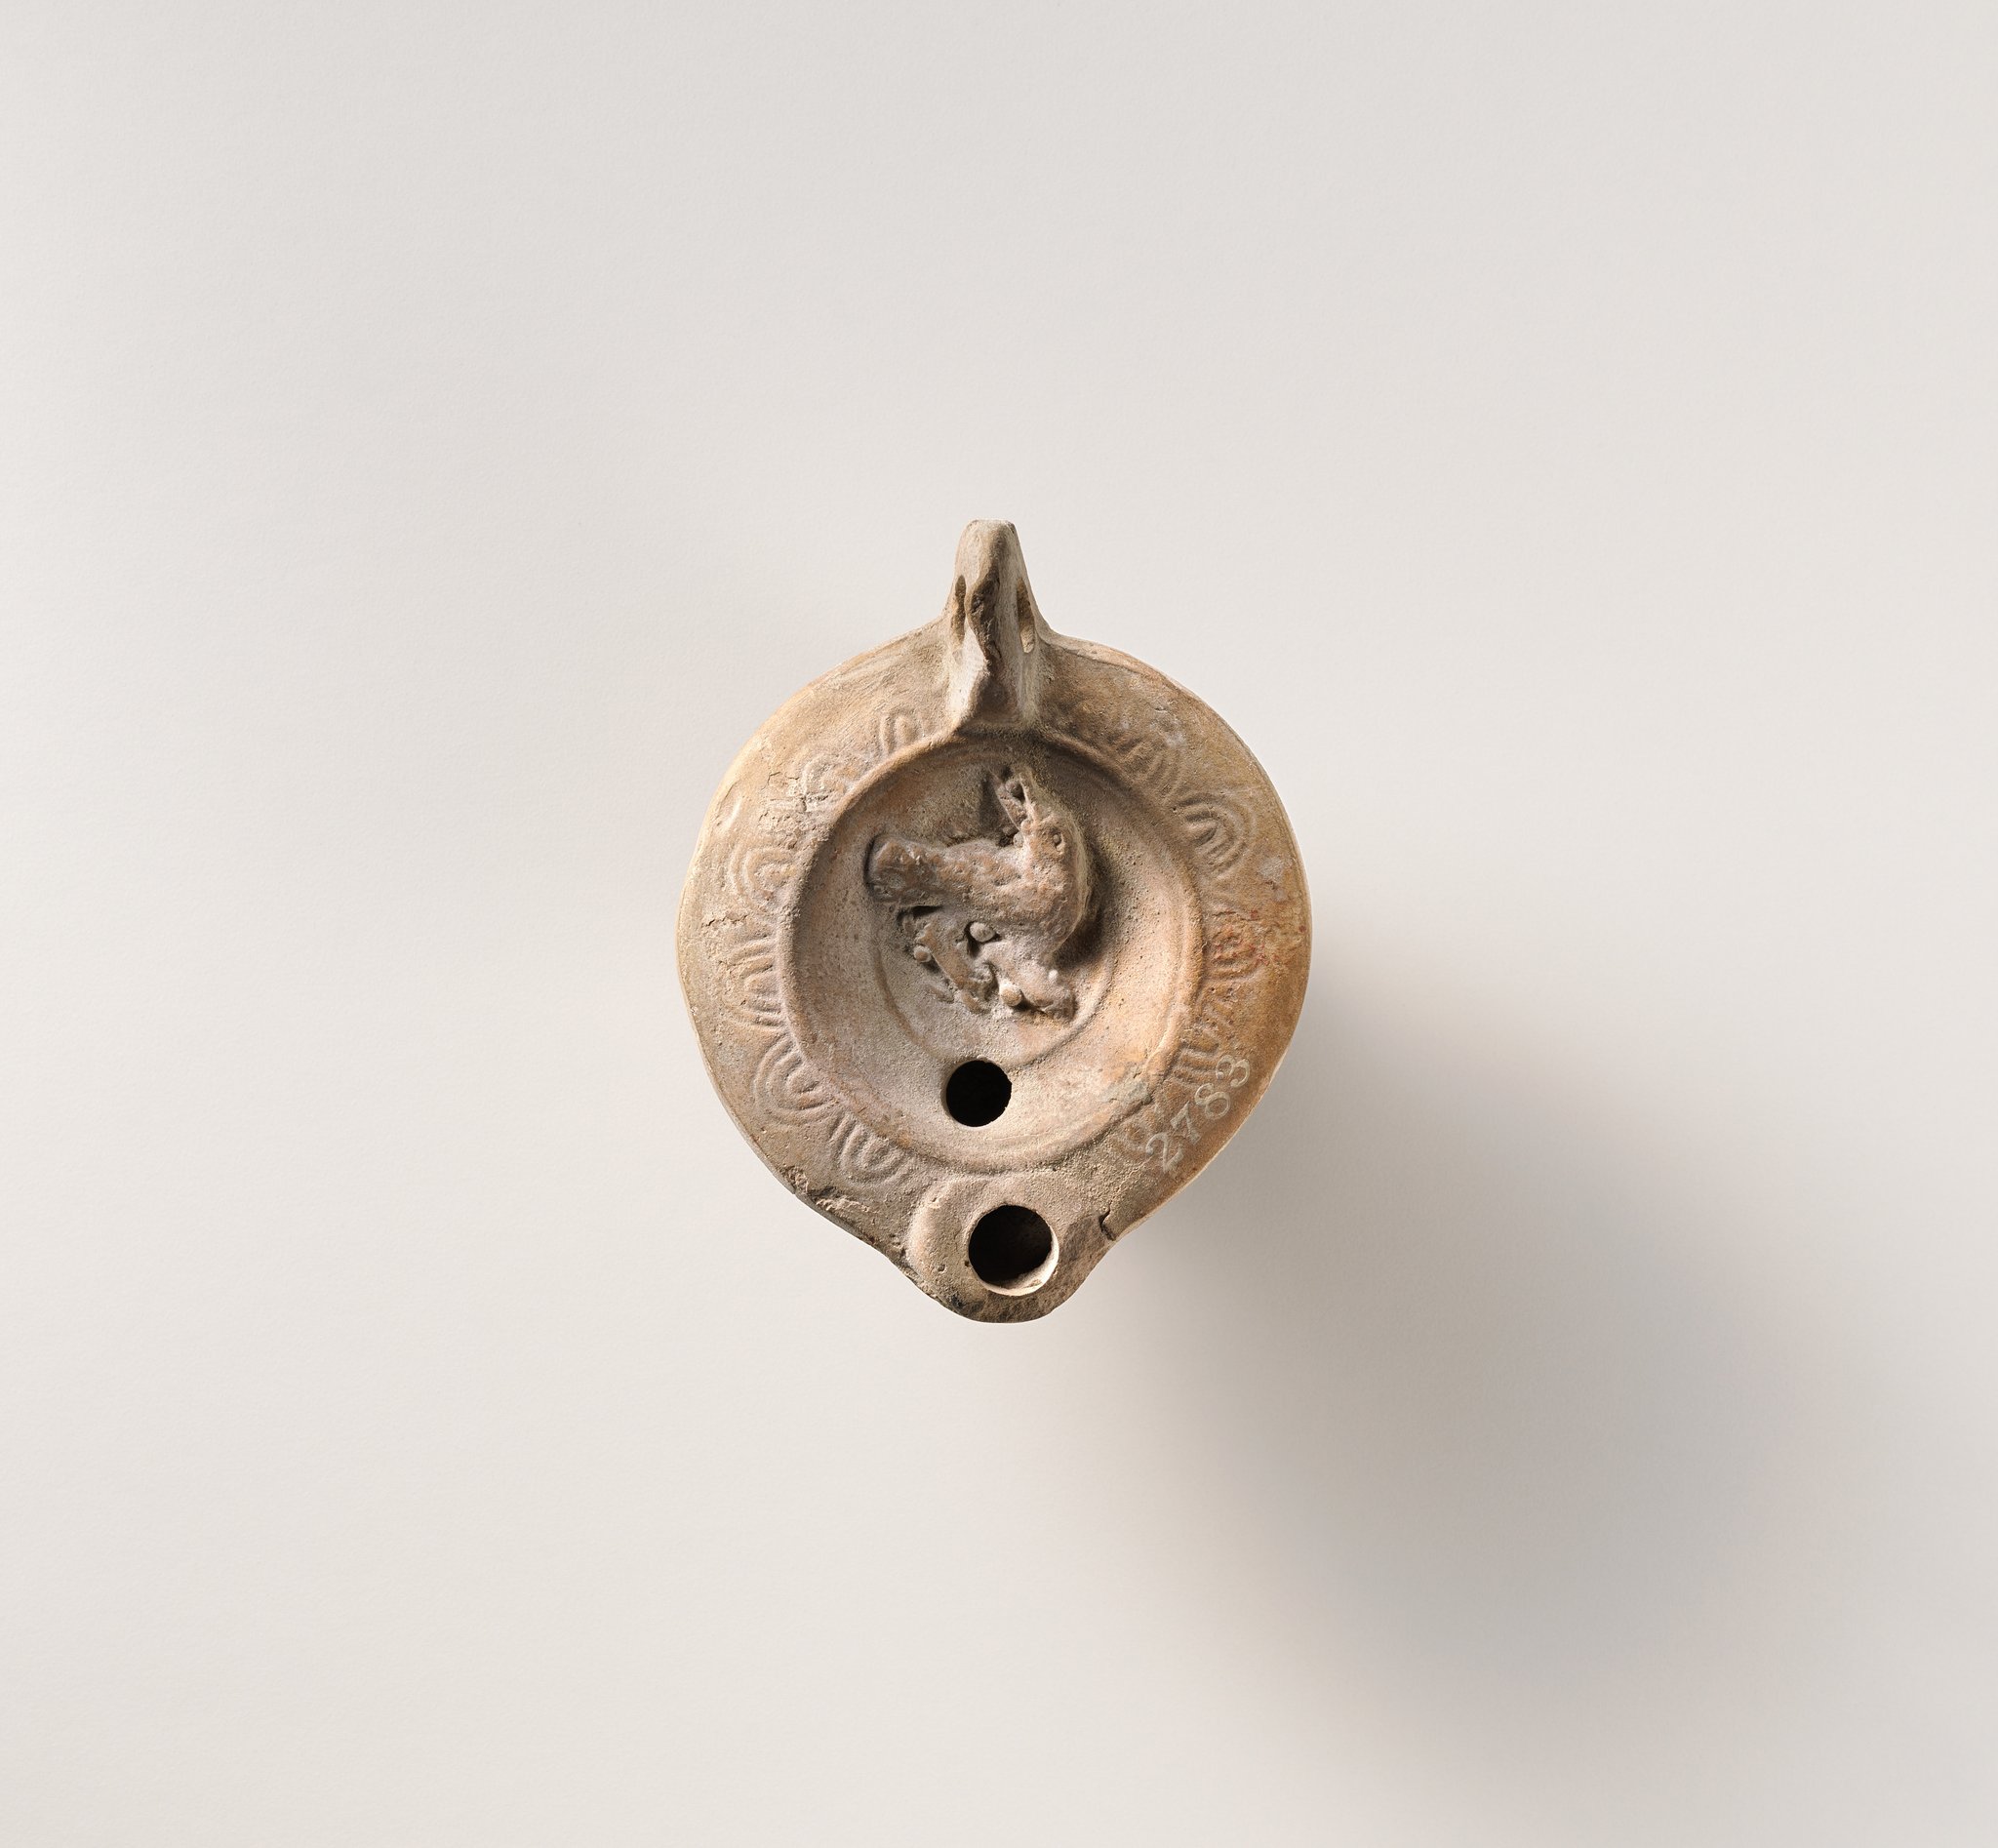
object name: lamp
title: Terracotta oil lamp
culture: roman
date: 101-200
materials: terracotta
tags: birds